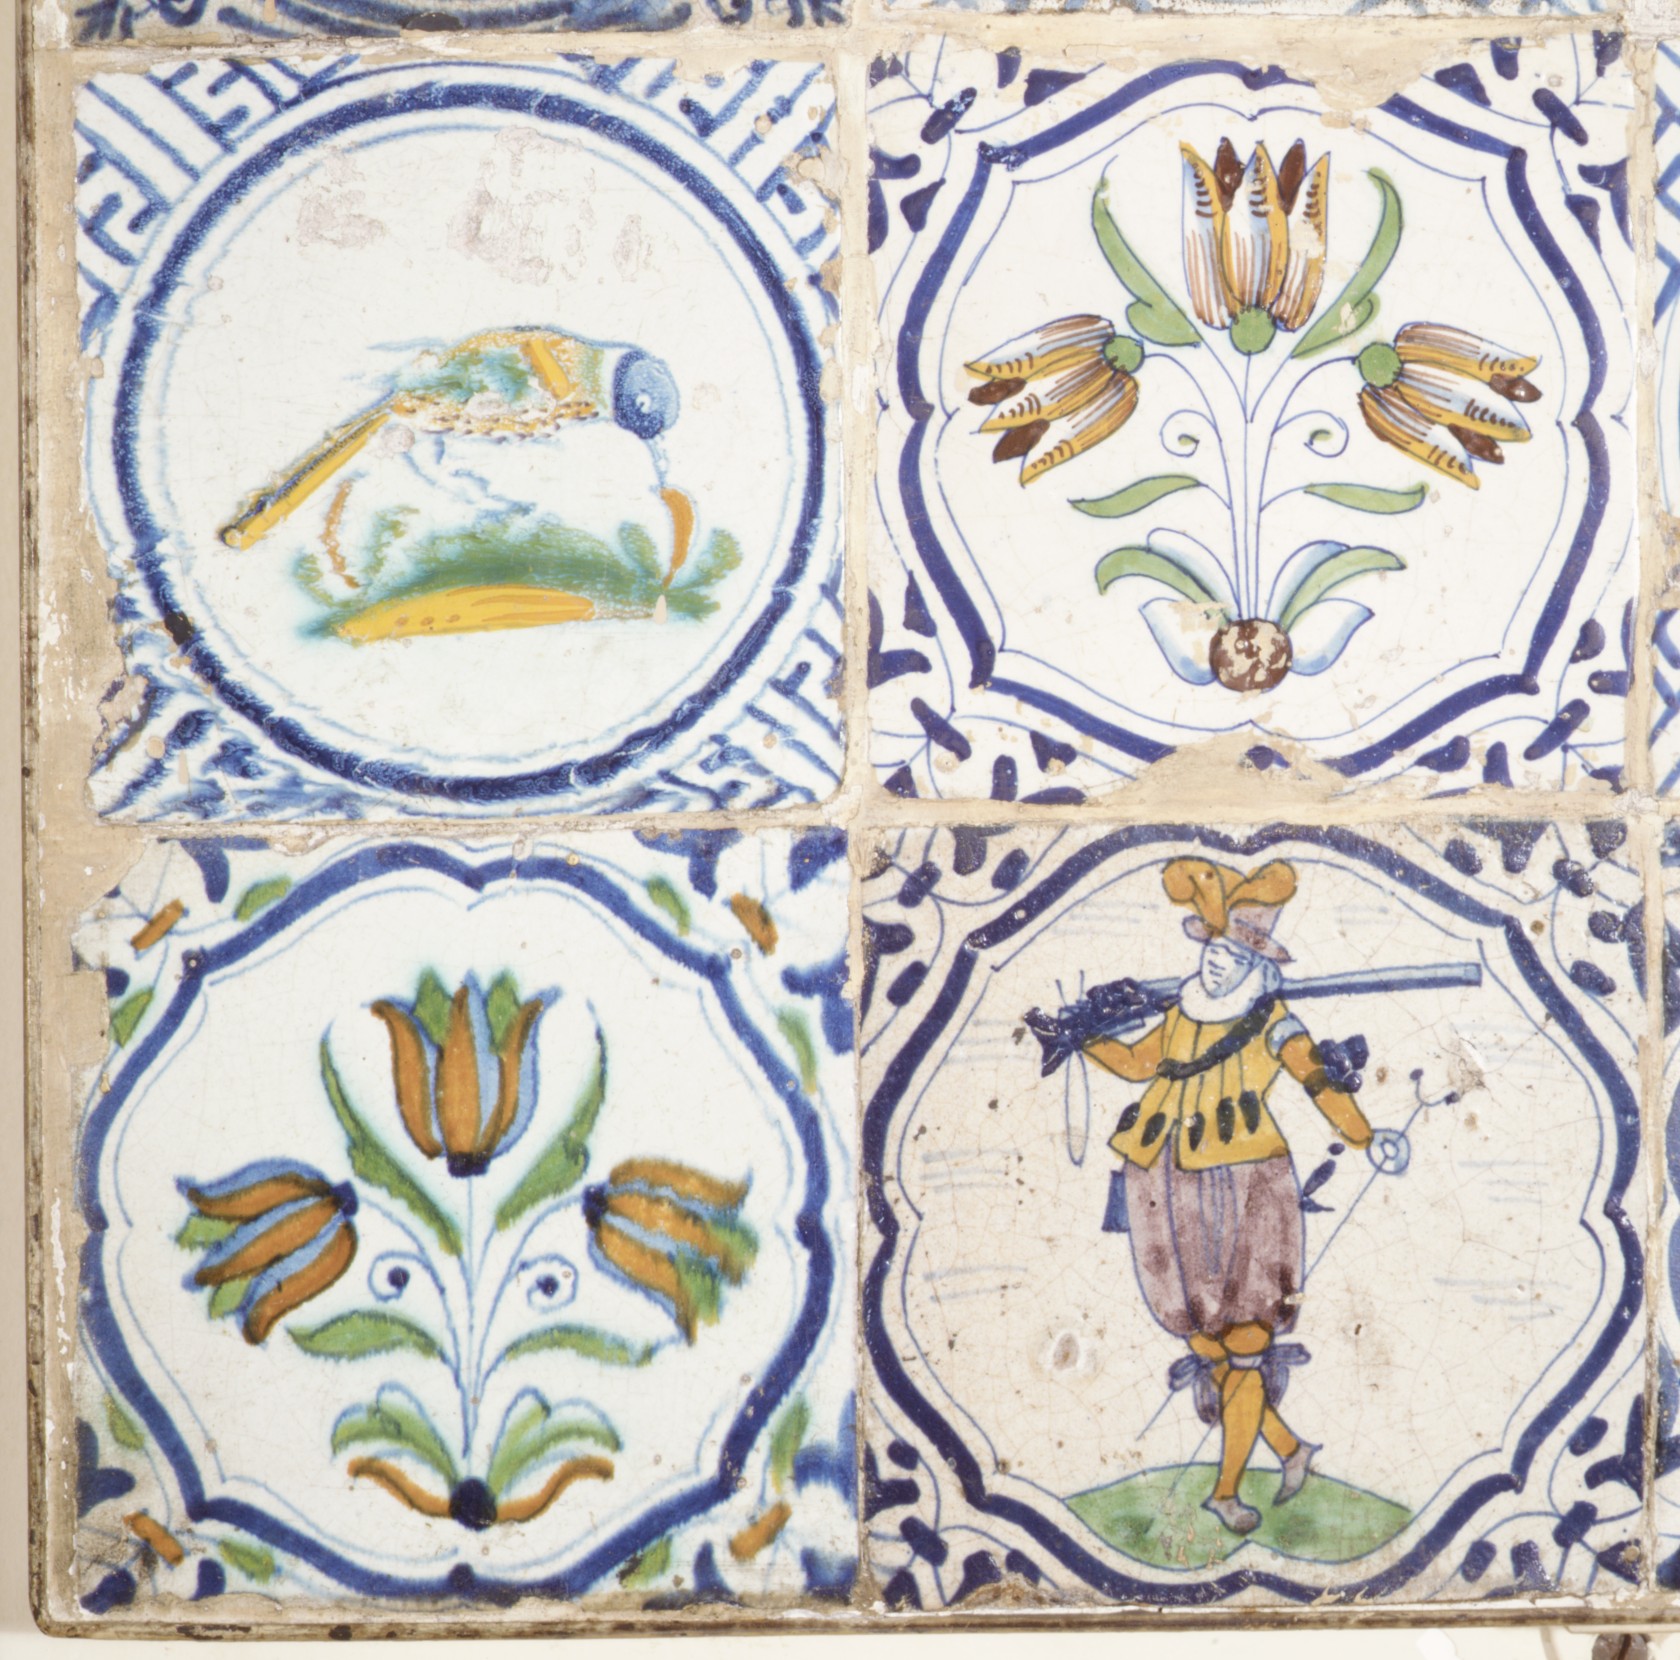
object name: tile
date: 1640-1660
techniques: glazing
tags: birds,men,flowers